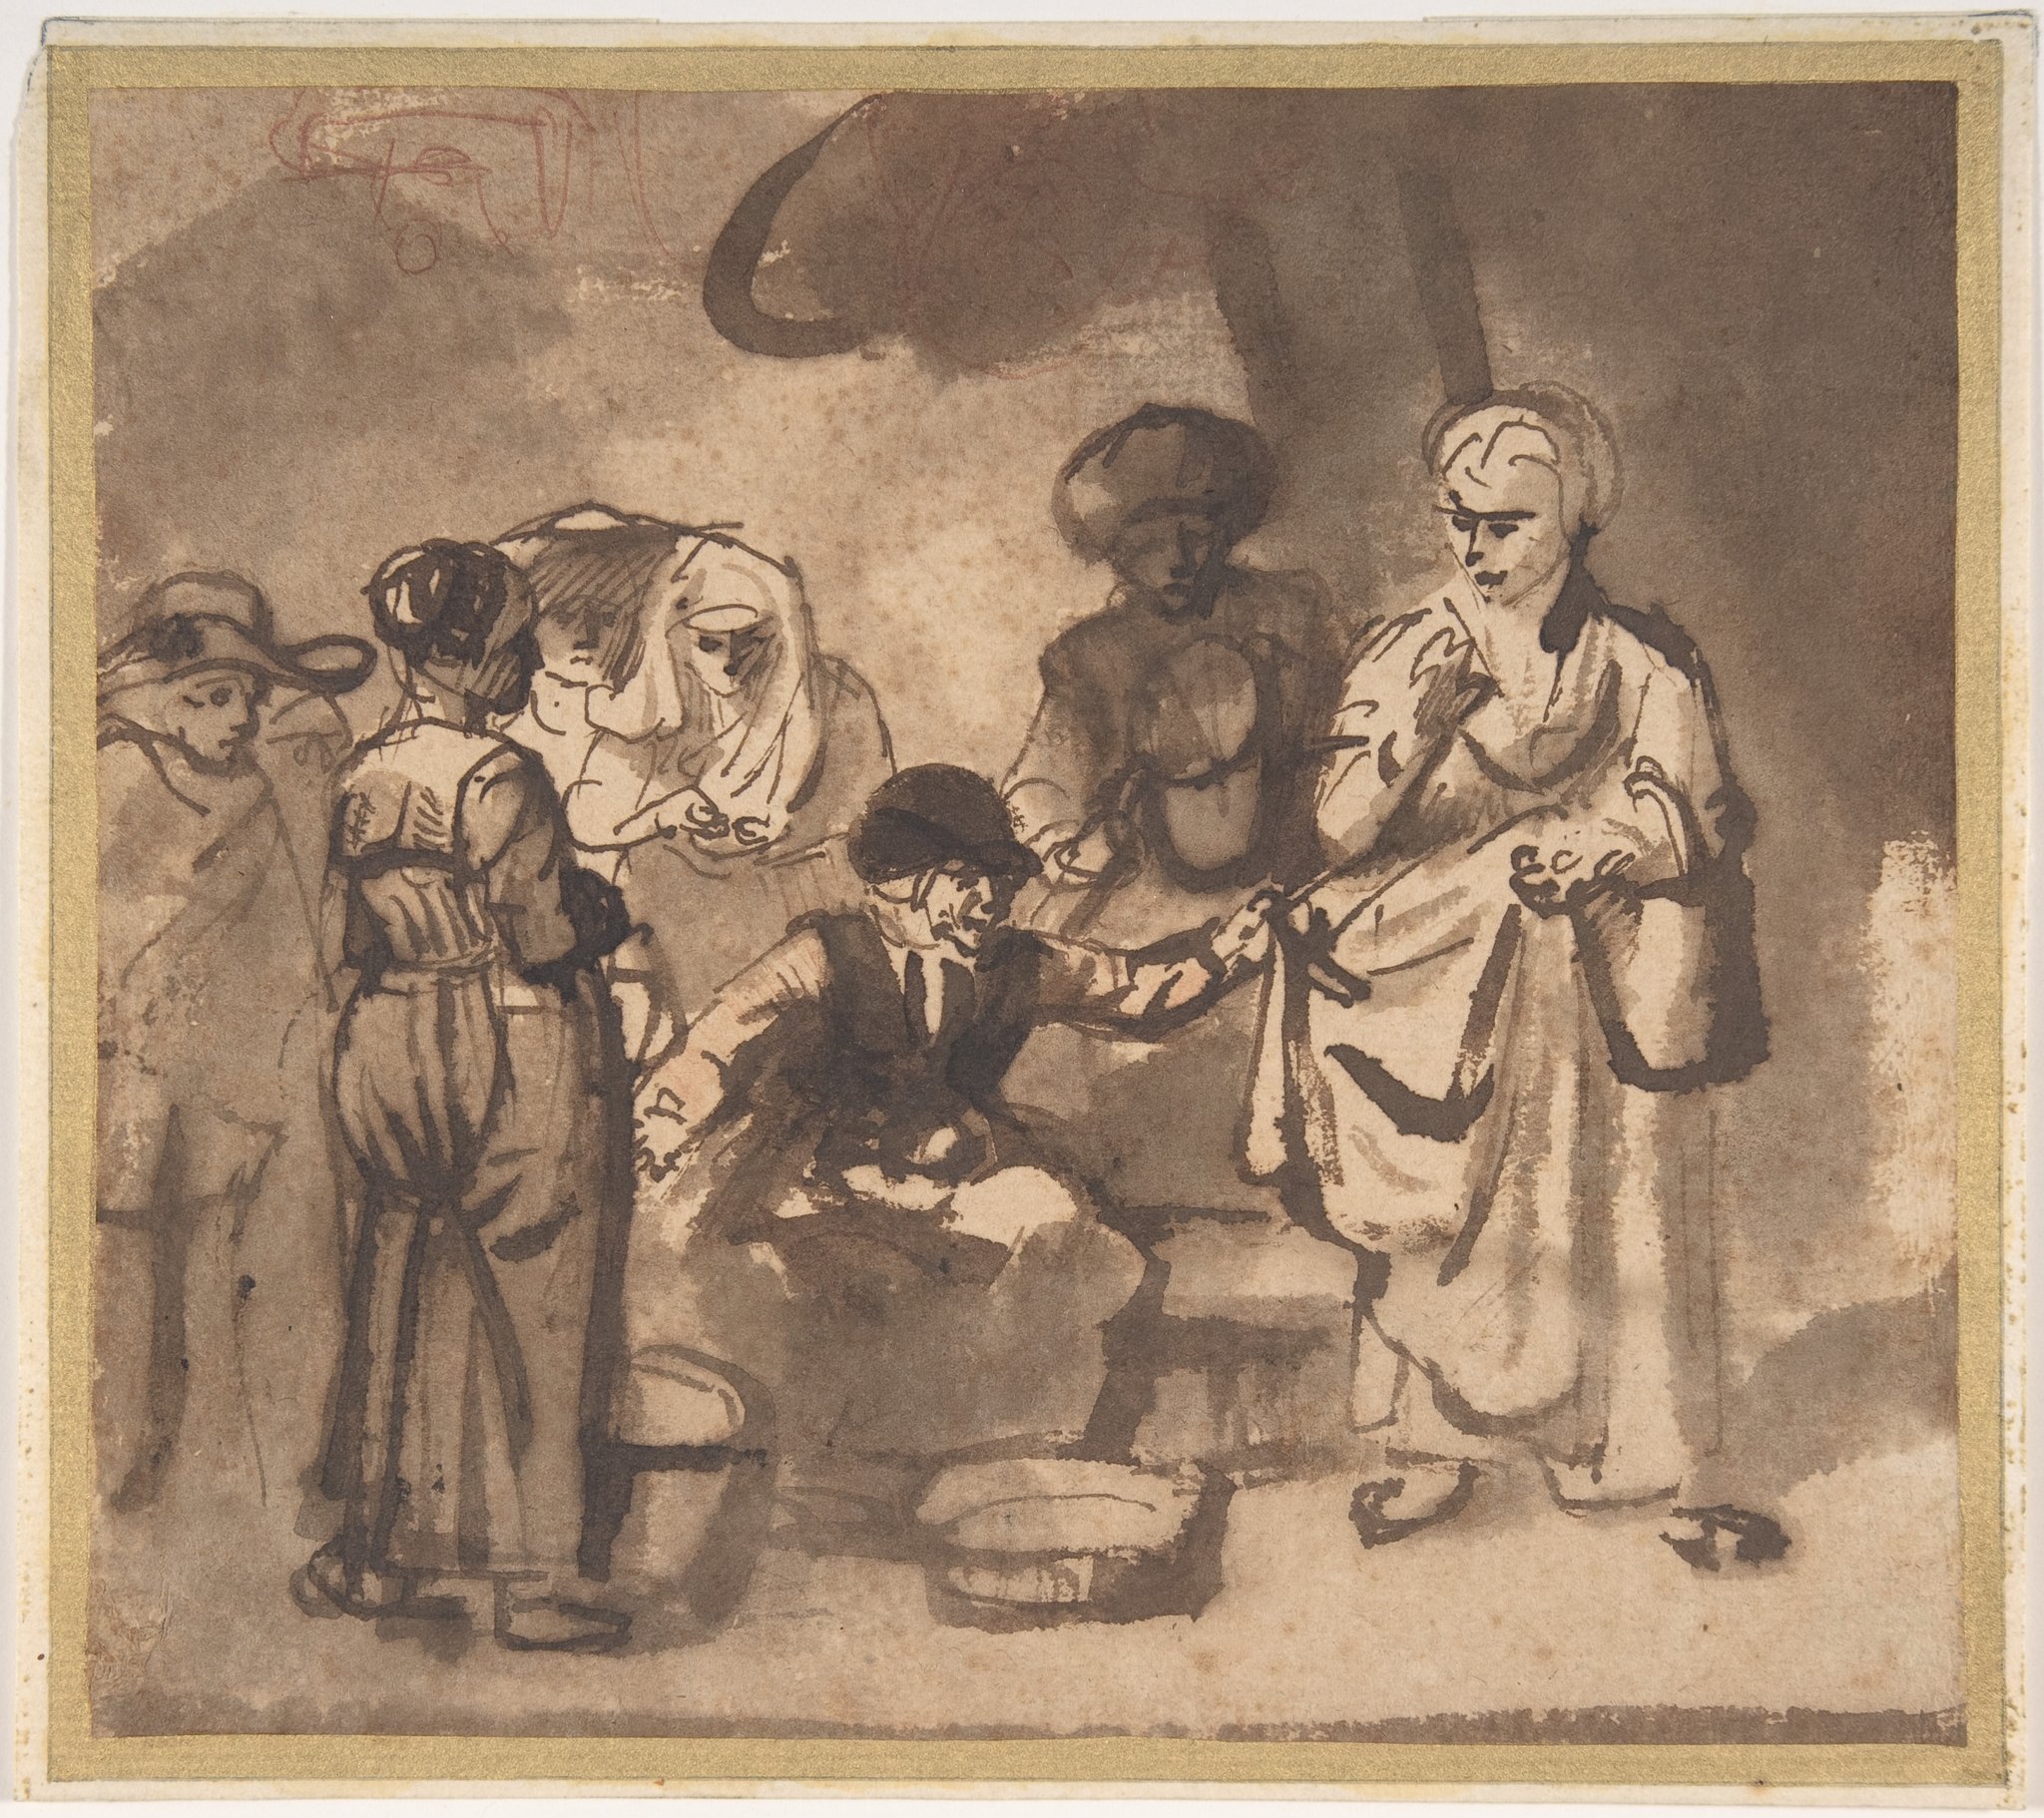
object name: drawing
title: The Scolding Fishwife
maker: nicolaes maes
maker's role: artist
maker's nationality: dutch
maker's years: 1634-1693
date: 1601-1700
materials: chalk, ink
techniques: brush, pen, wash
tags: anger,men,women